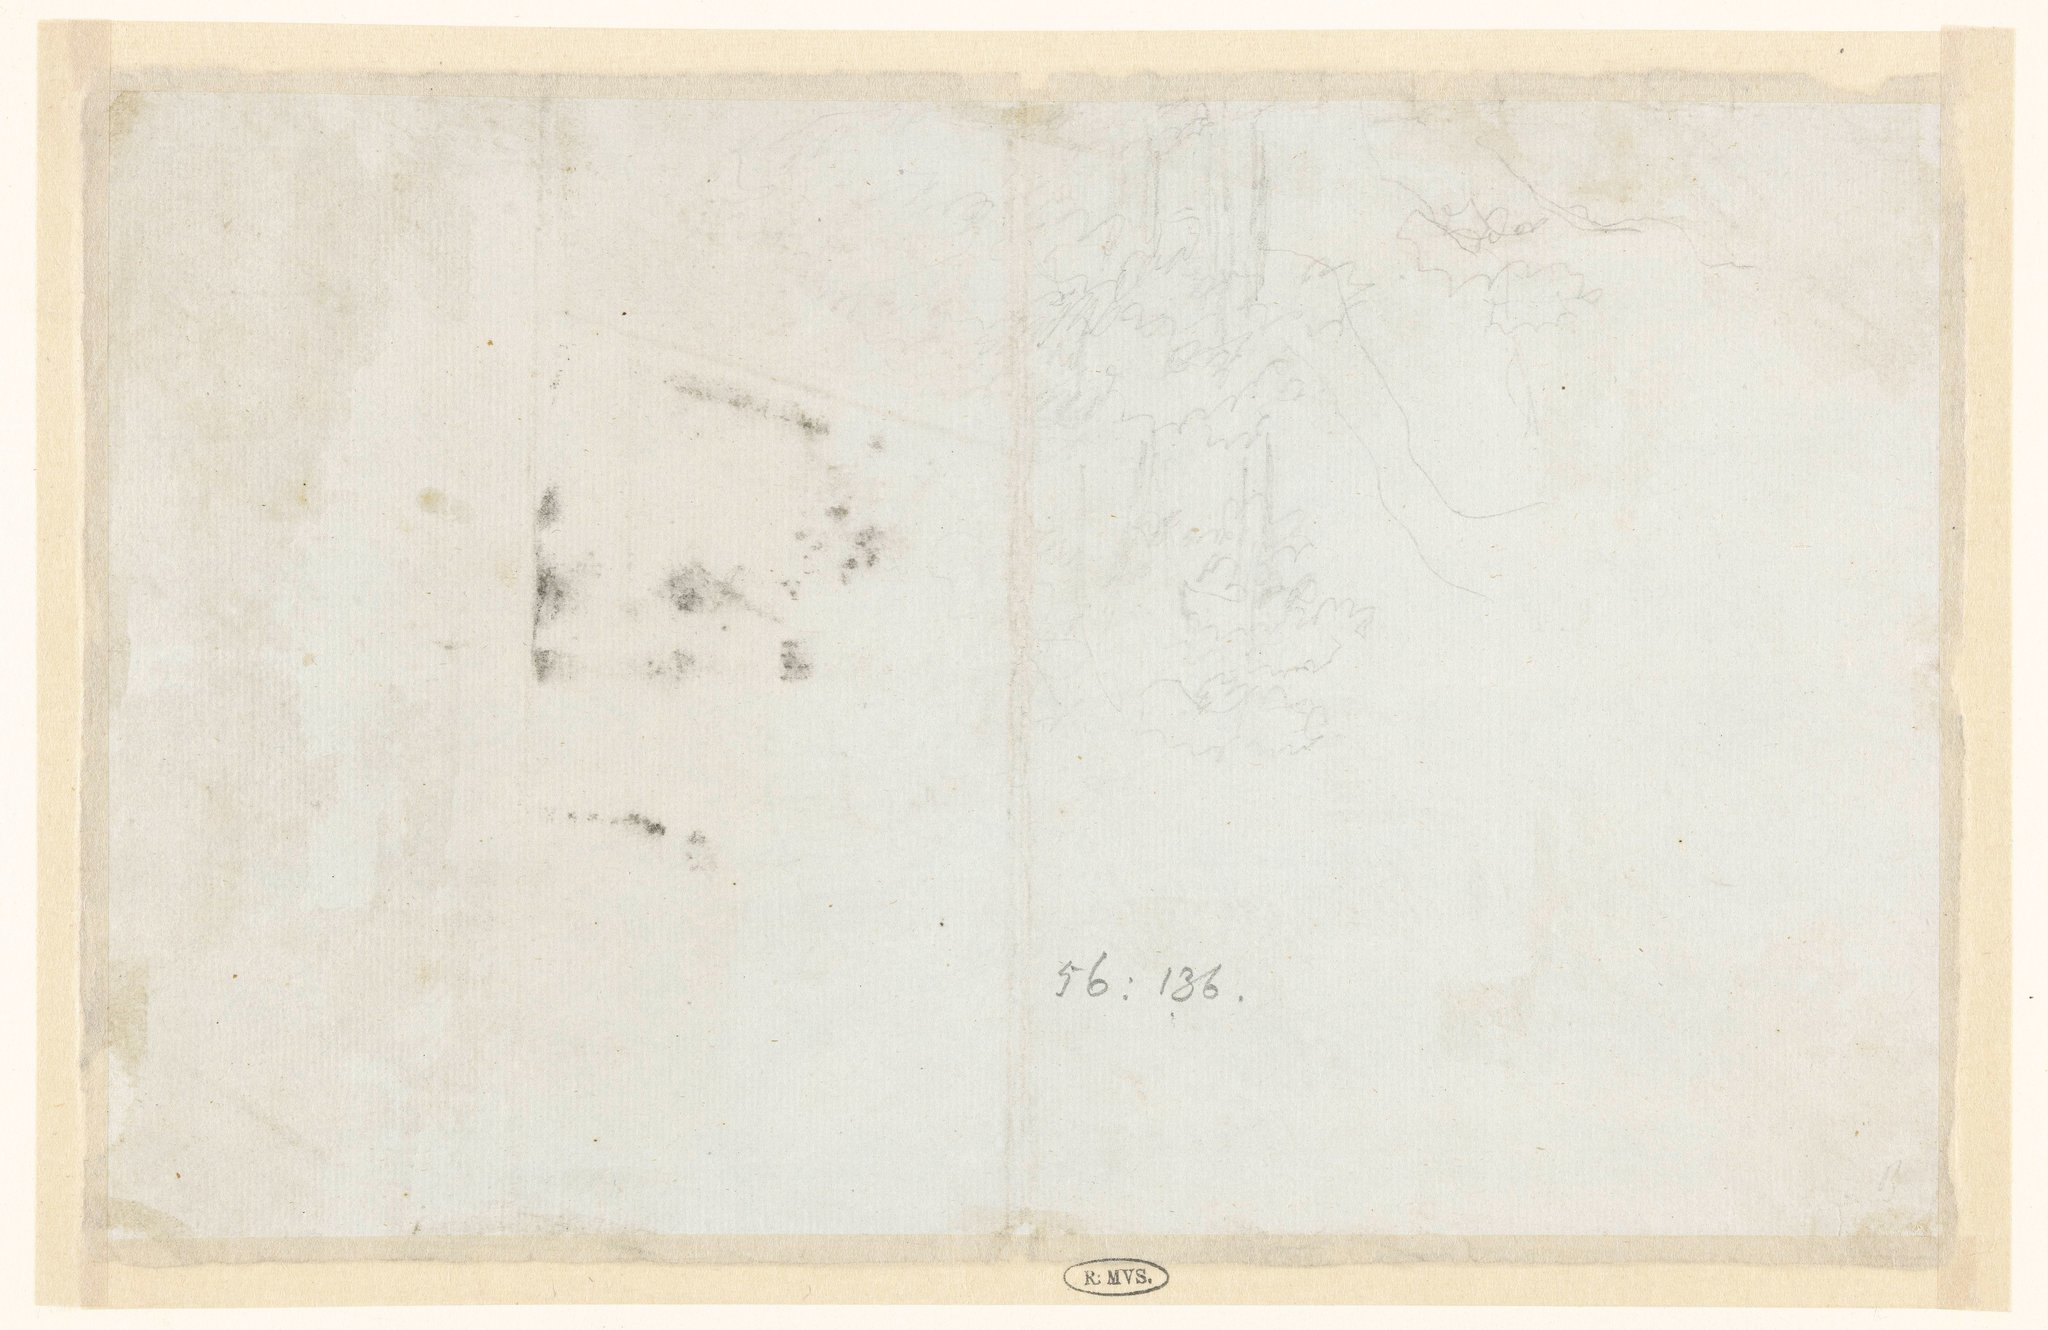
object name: drawing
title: Schets met enkele bomen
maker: david alphonse de sandoz-rollin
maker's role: draughtsman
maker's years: 1740-1809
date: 1750-1809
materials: paper, pencil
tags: trees